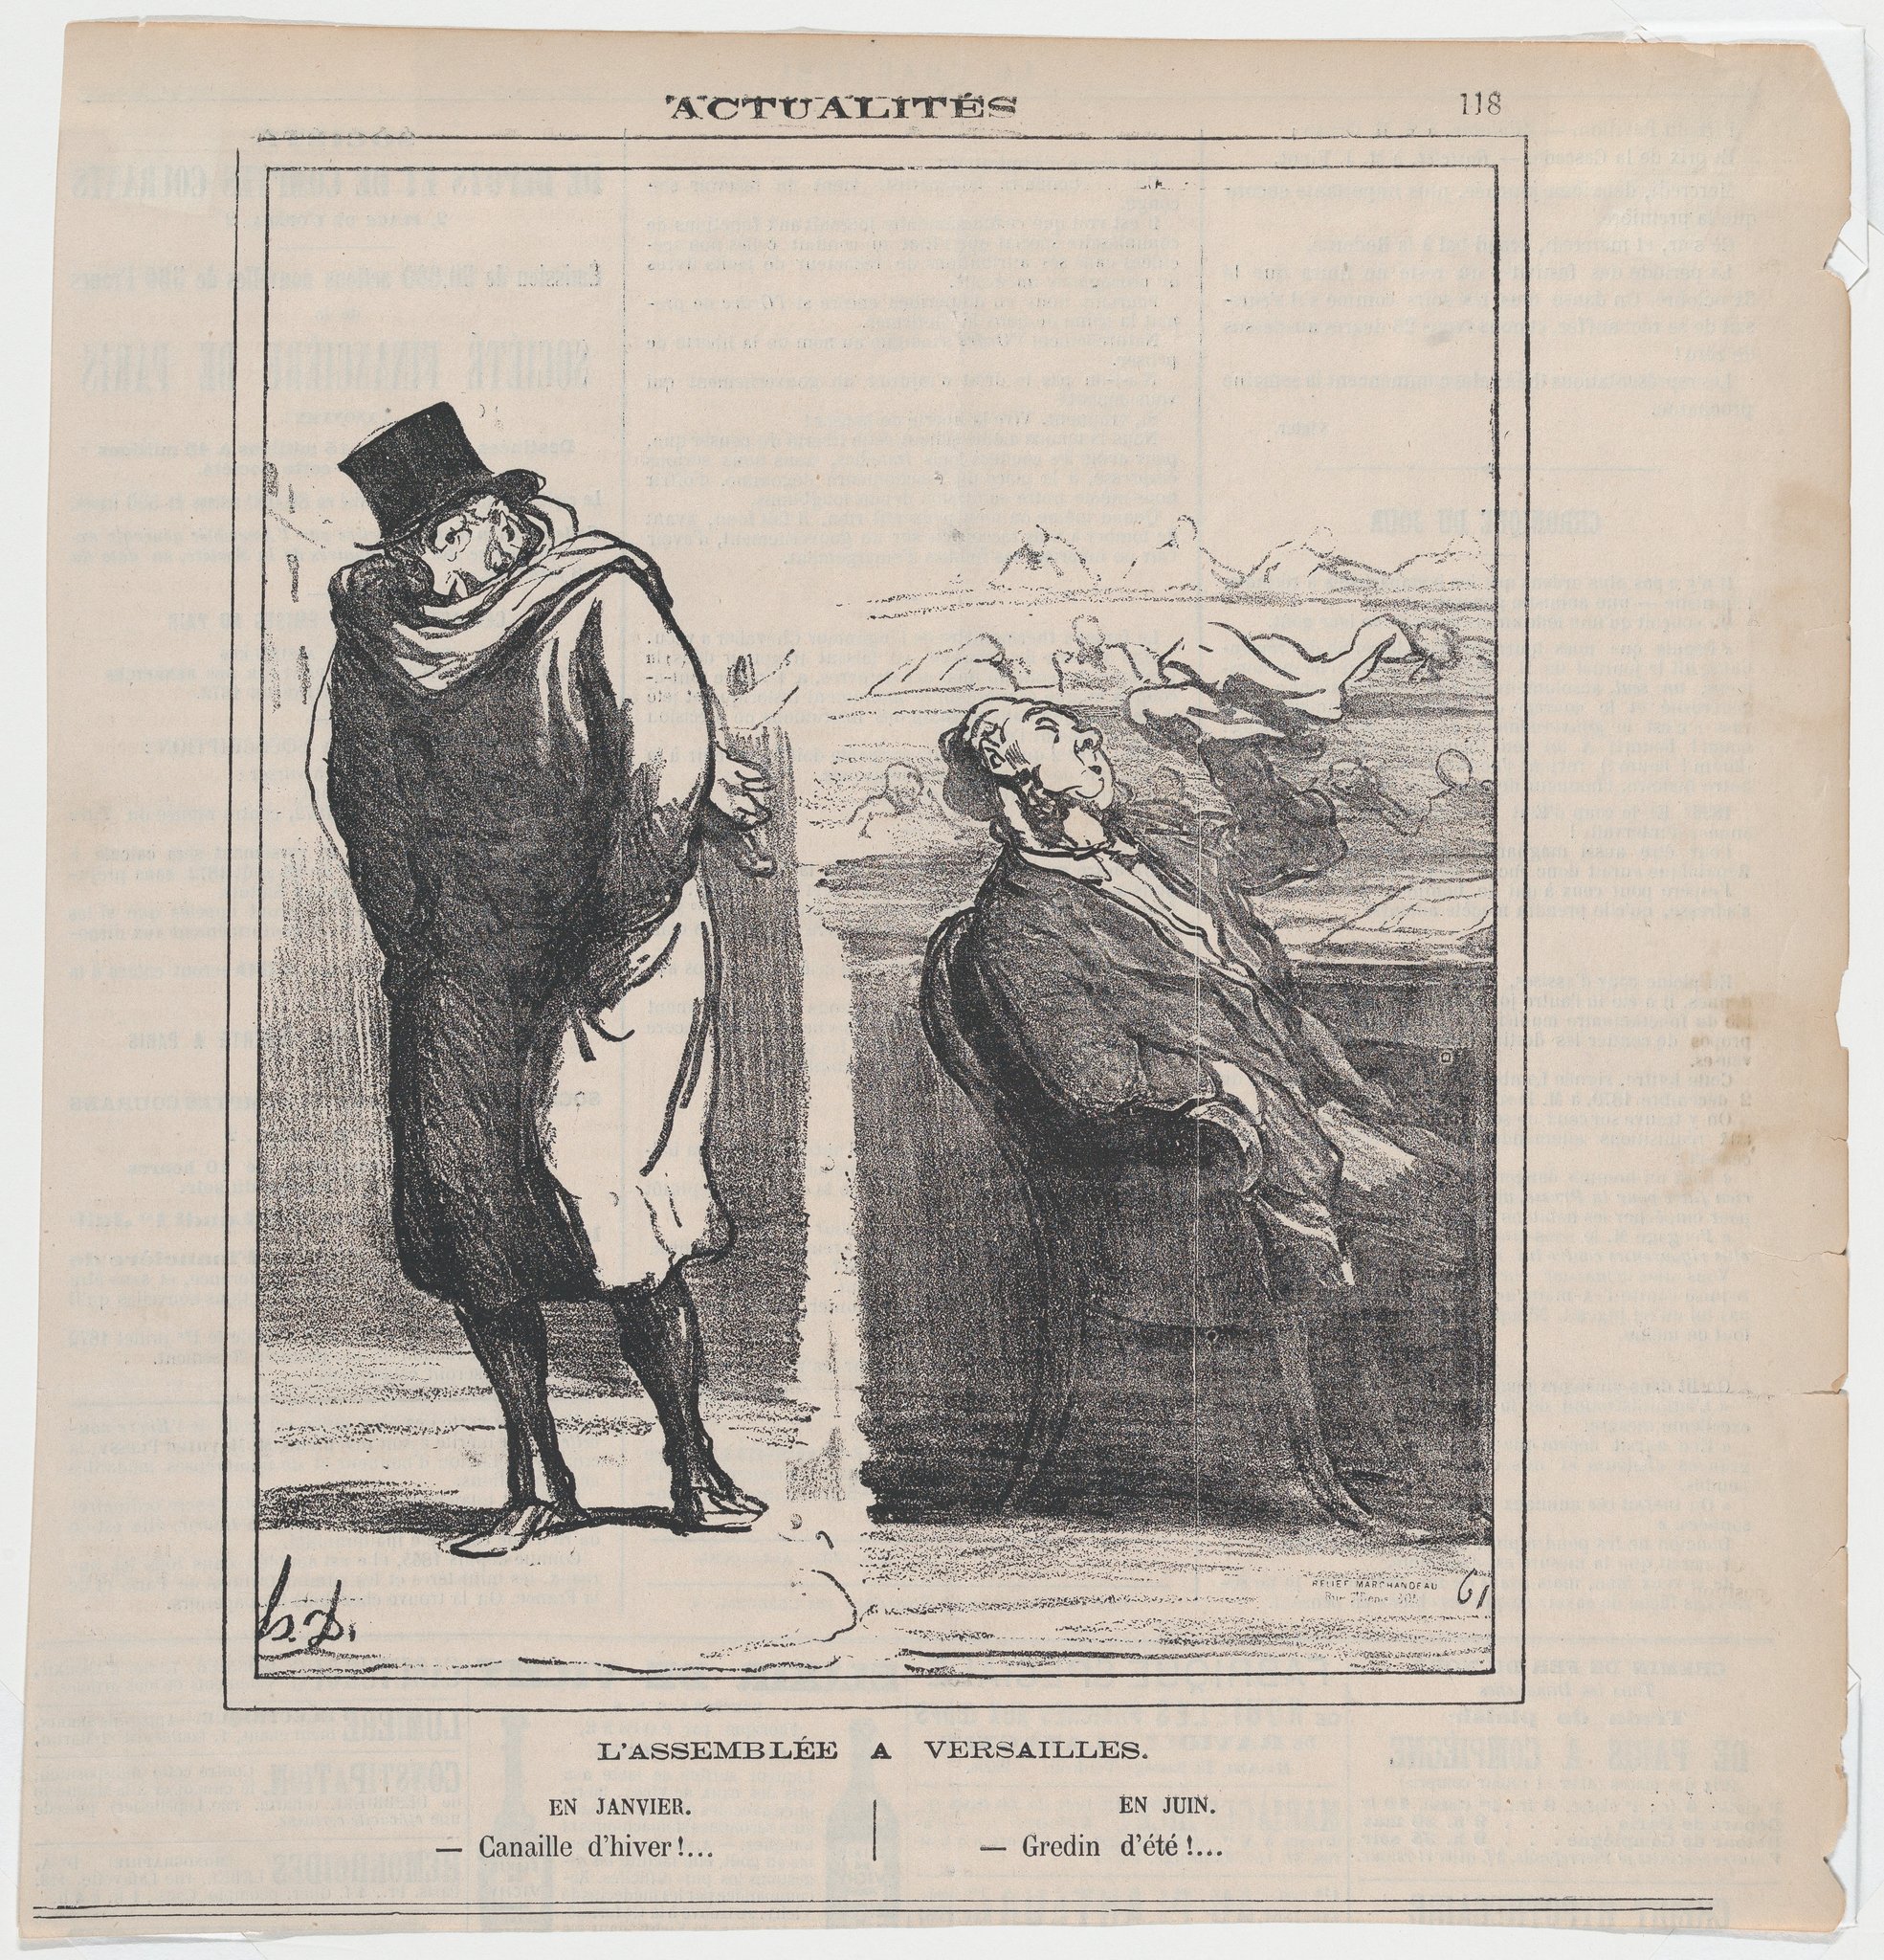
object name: print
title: The assemby in Versailles: In January –Wretched winter!... In June –Scoundrel of a summer!...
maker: honoré daumier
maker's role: artist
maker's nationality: french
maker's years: 1808-1879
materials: paper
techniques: lithograph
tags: hats,men,summer,winter,chairs